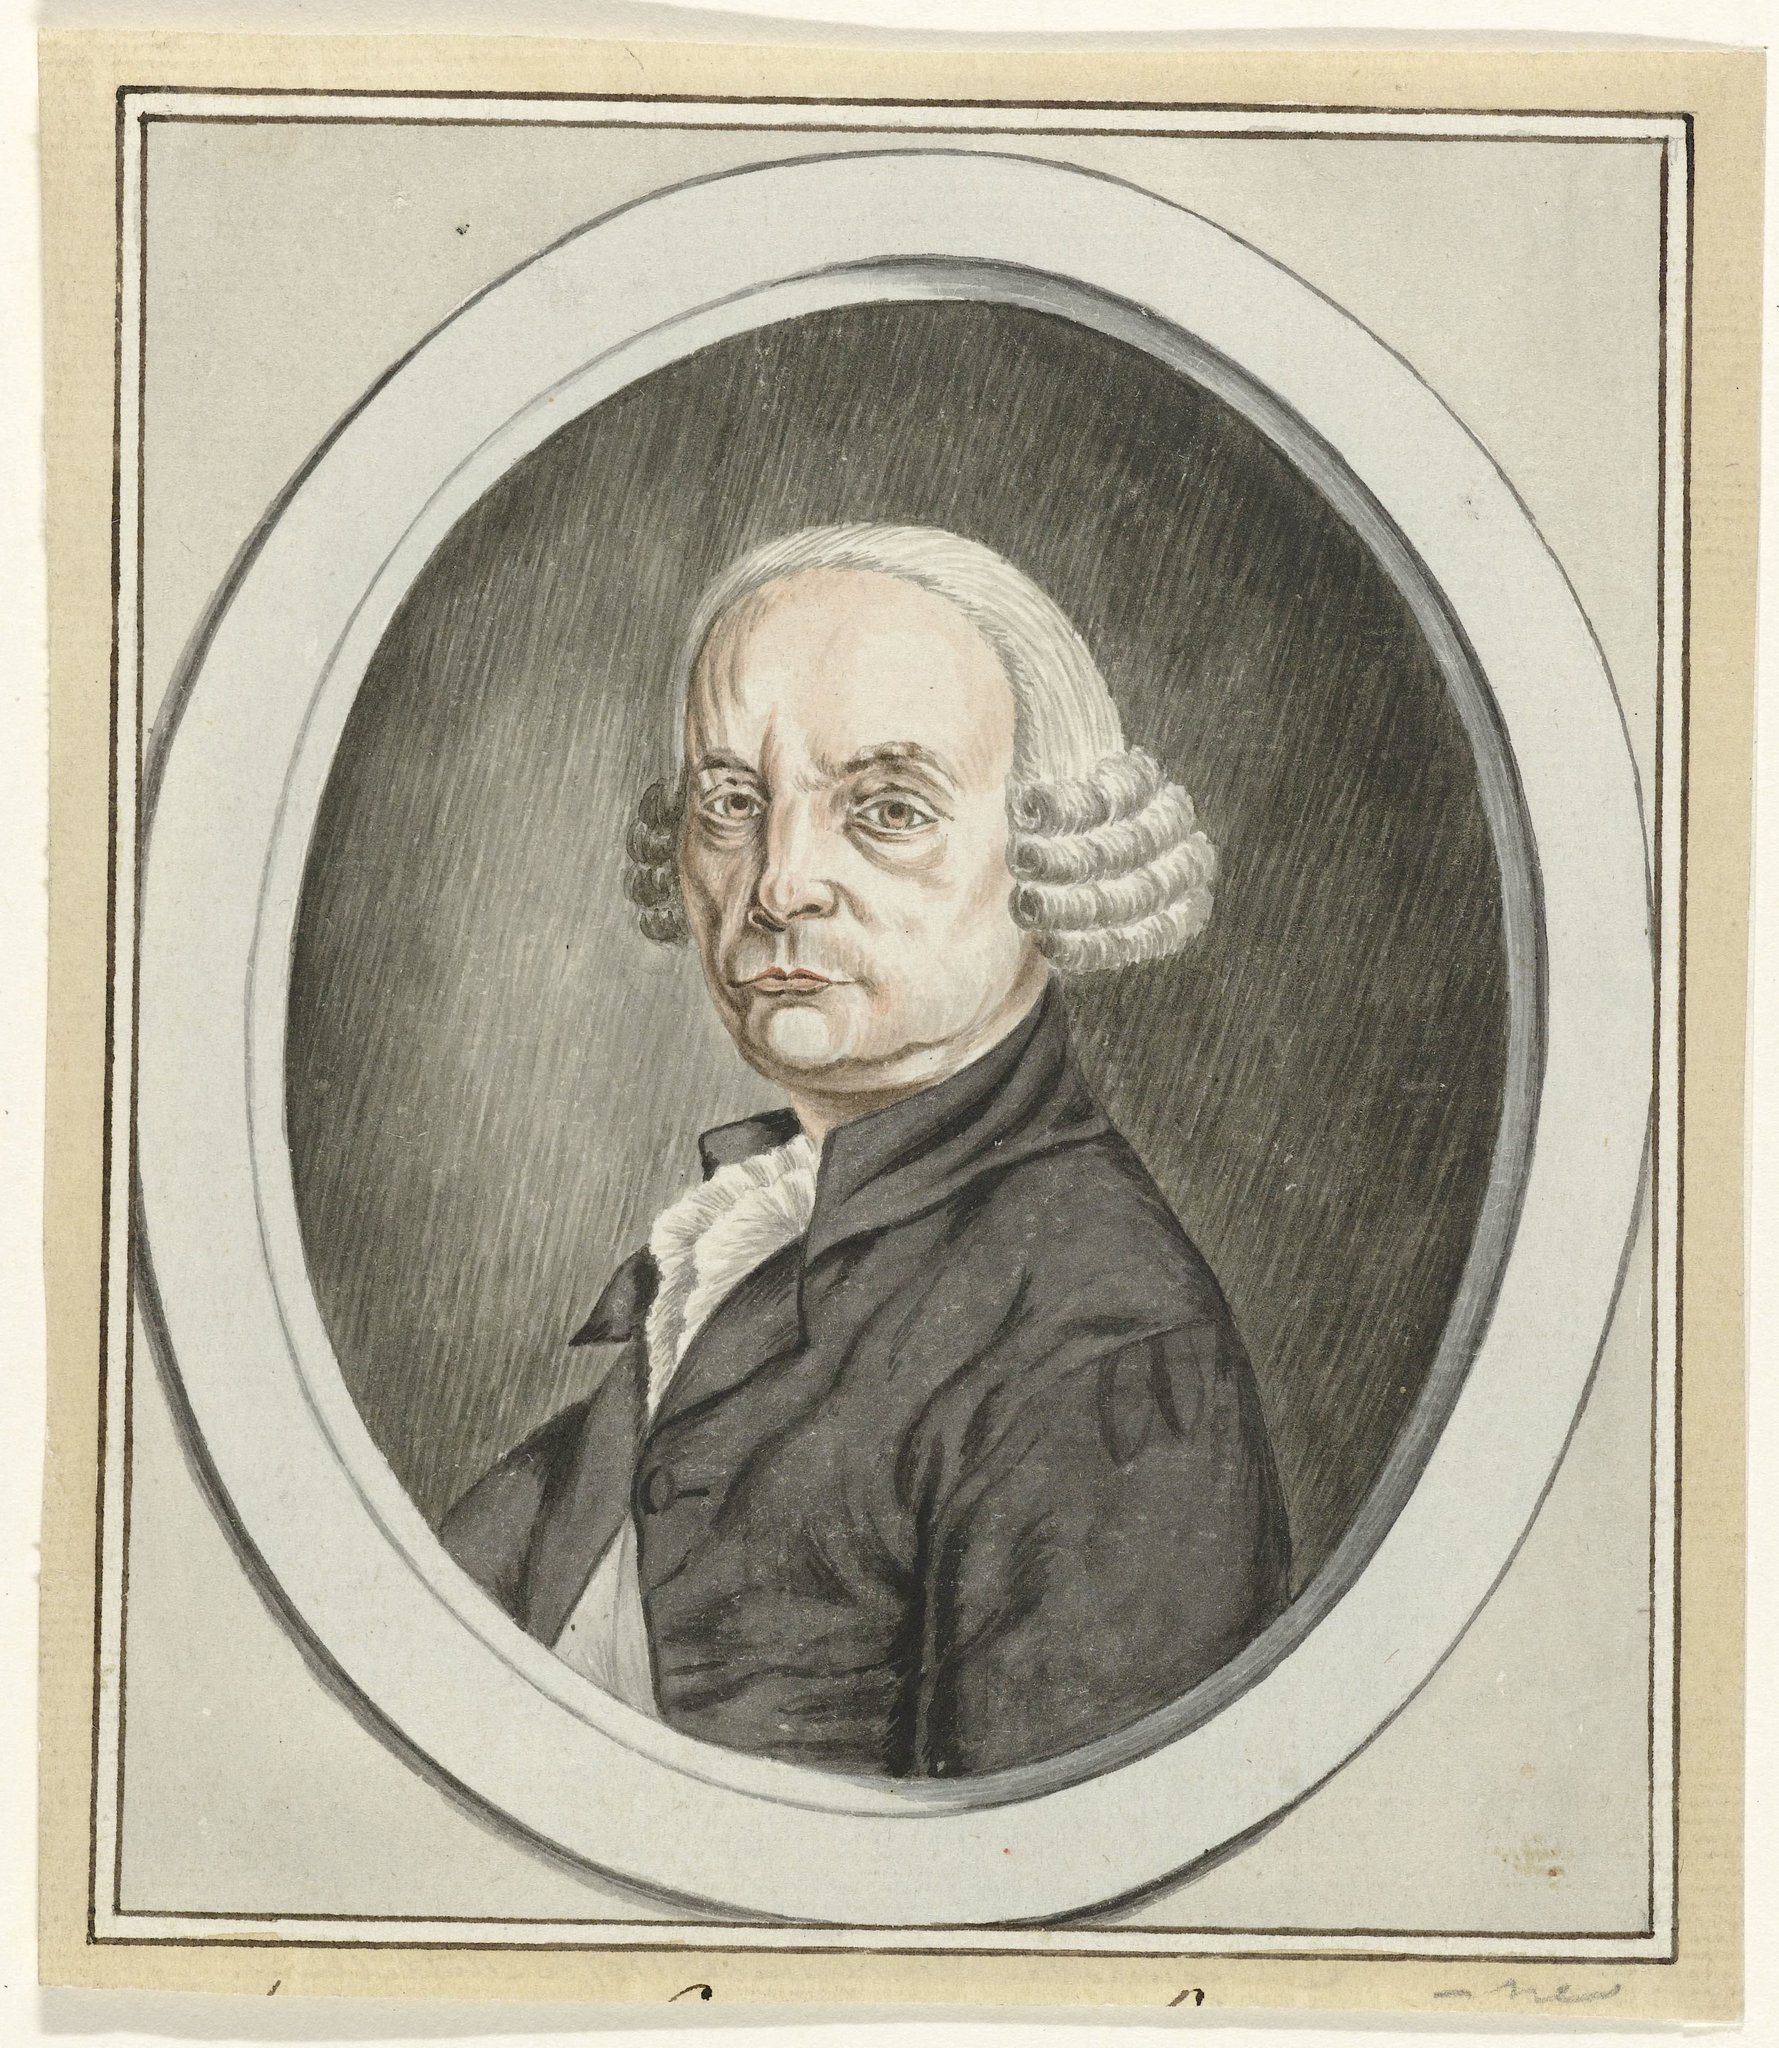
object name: drawing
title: Portret van Lucas van Steveninck, 1787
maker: Anonymous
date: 1787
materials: paper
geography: northern netherlands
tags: amsterdam, middelburg, patriots (1780-1795)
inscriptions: collector's mark: Lugt 2228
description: Portret van de patriotse arts Lucas van Steveninck, in ovaal naar links. Mogelijk naar aanleiding van de beschieting en plundering van zijn huis in Middelburg in 1787.